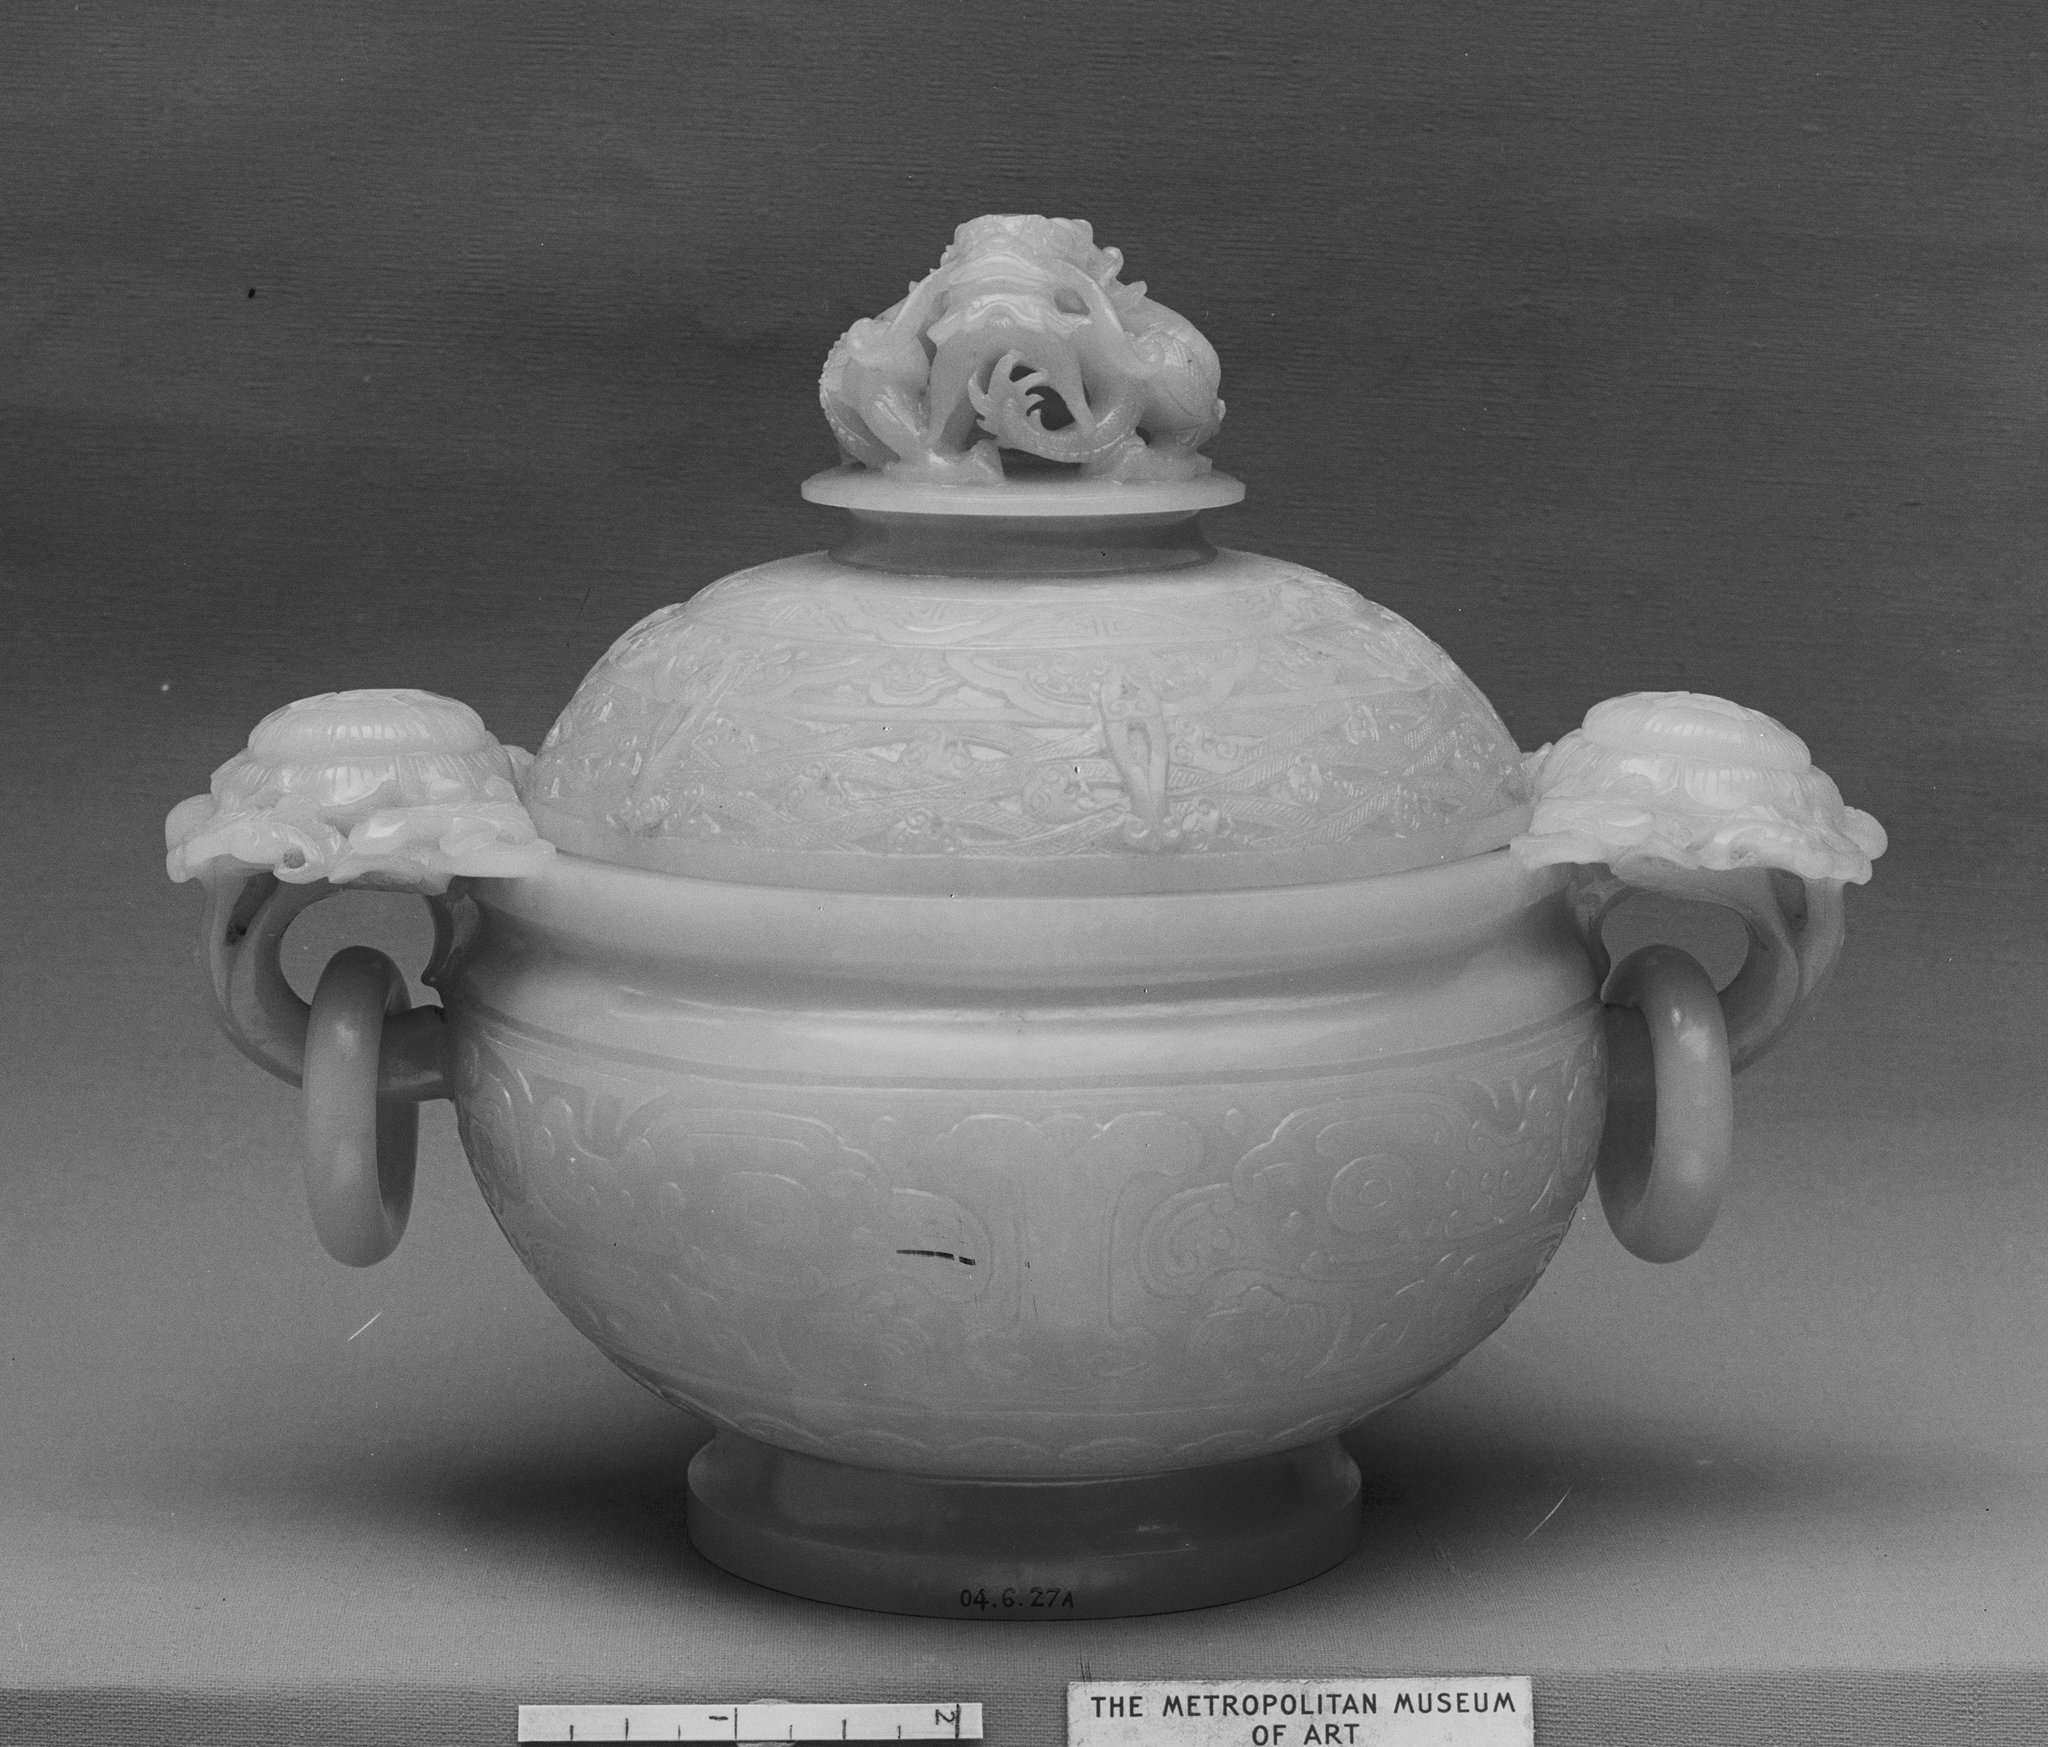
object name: incense burner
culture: chinese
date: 1701-1800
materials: jade